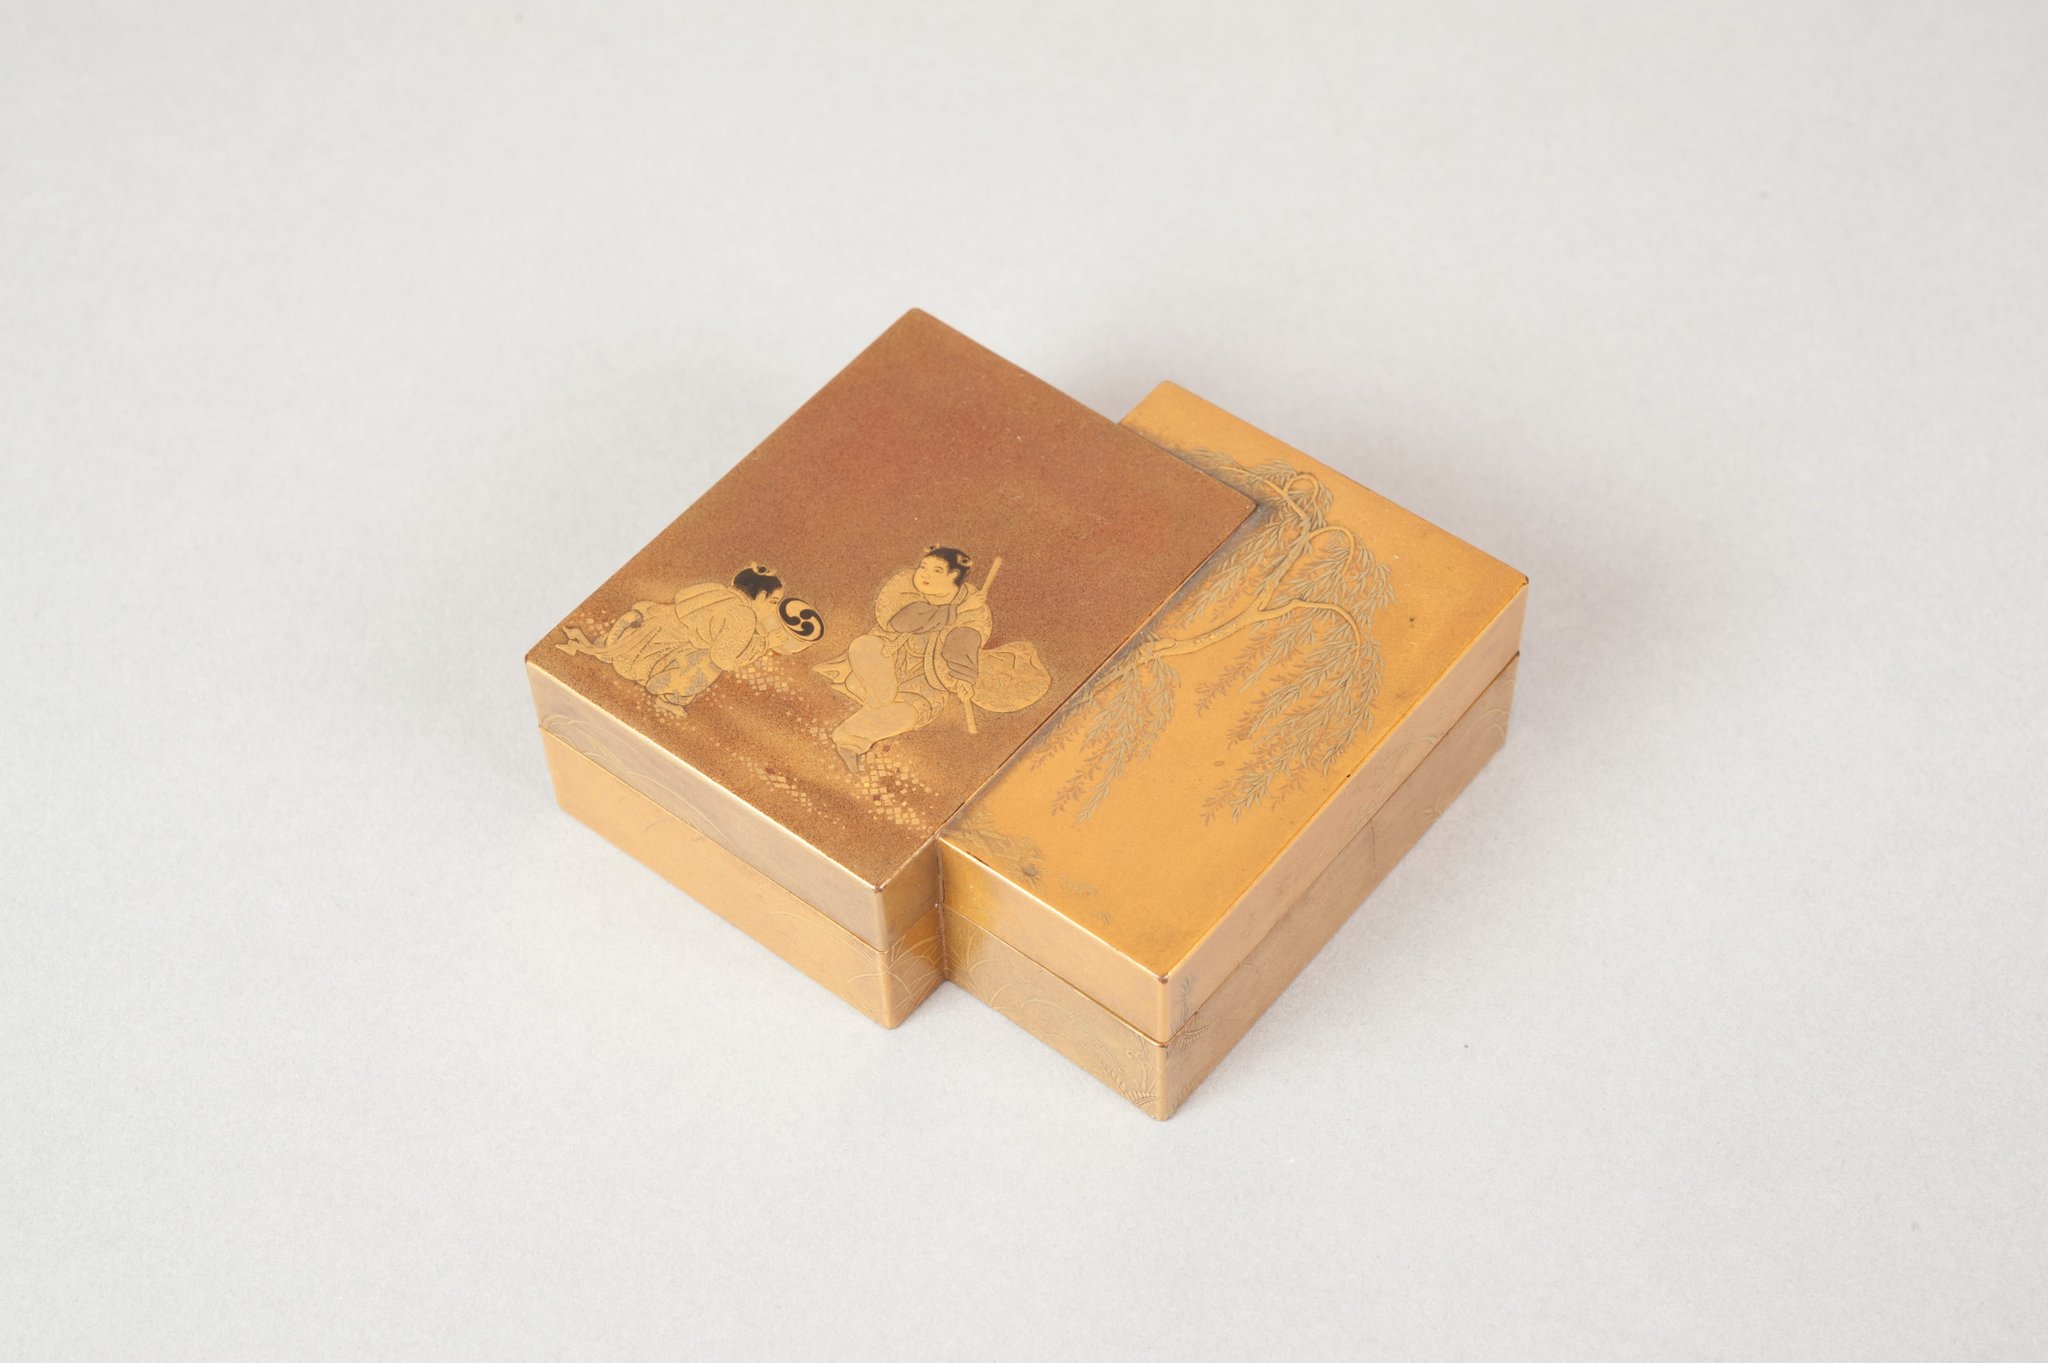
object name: box with tray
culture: japanese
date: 1801-1900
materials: gold, lacquer